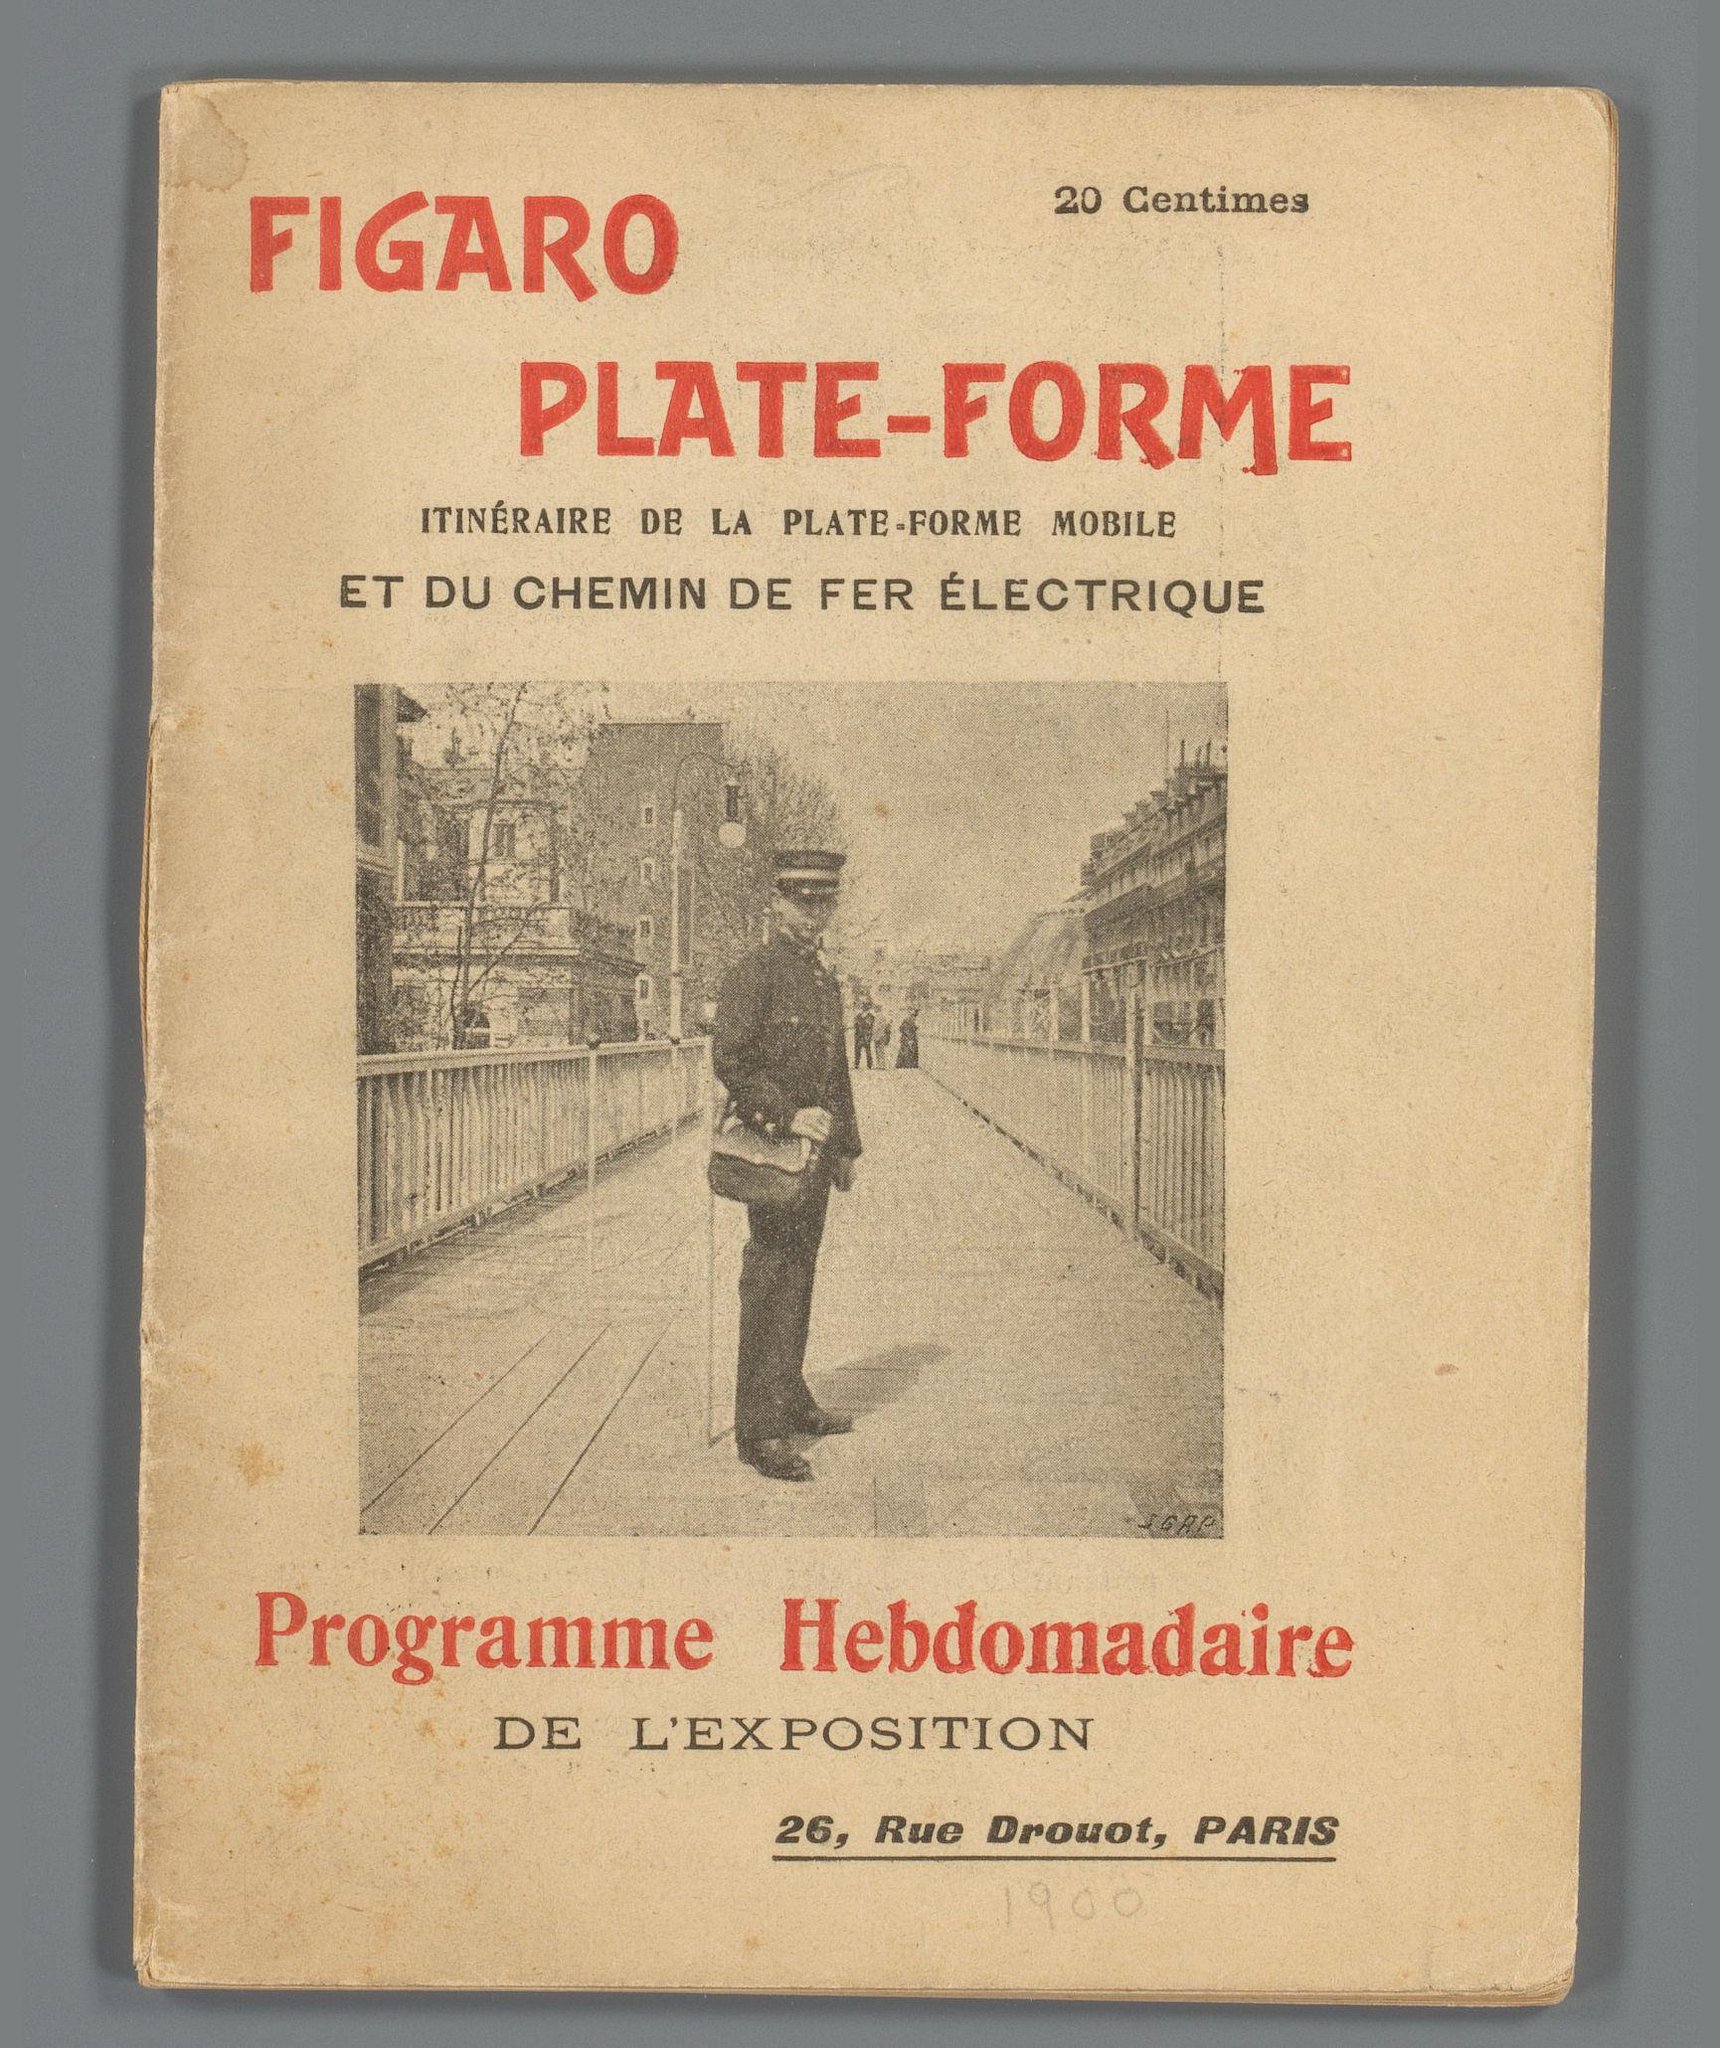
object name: photomechanical print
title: Figaro Plate-forme: intinéraire de la plate-forme mobile et du chemin de fer électrique. Programme Hebdomadaire de l'Exposition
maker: Anonymous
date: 1900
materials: paper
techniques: bookbinding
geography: paris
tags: arm raised upward - aa - both arms or hands, physiology and anatomy, collection, exhibition, show, paris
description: Figaro Plate-forme: intinéraire de la plate-forme mobile et du chemin de fer électrique. Programme Hebdomadaire de l'Exposition. Parijs: Éditions Figaro, 1900.